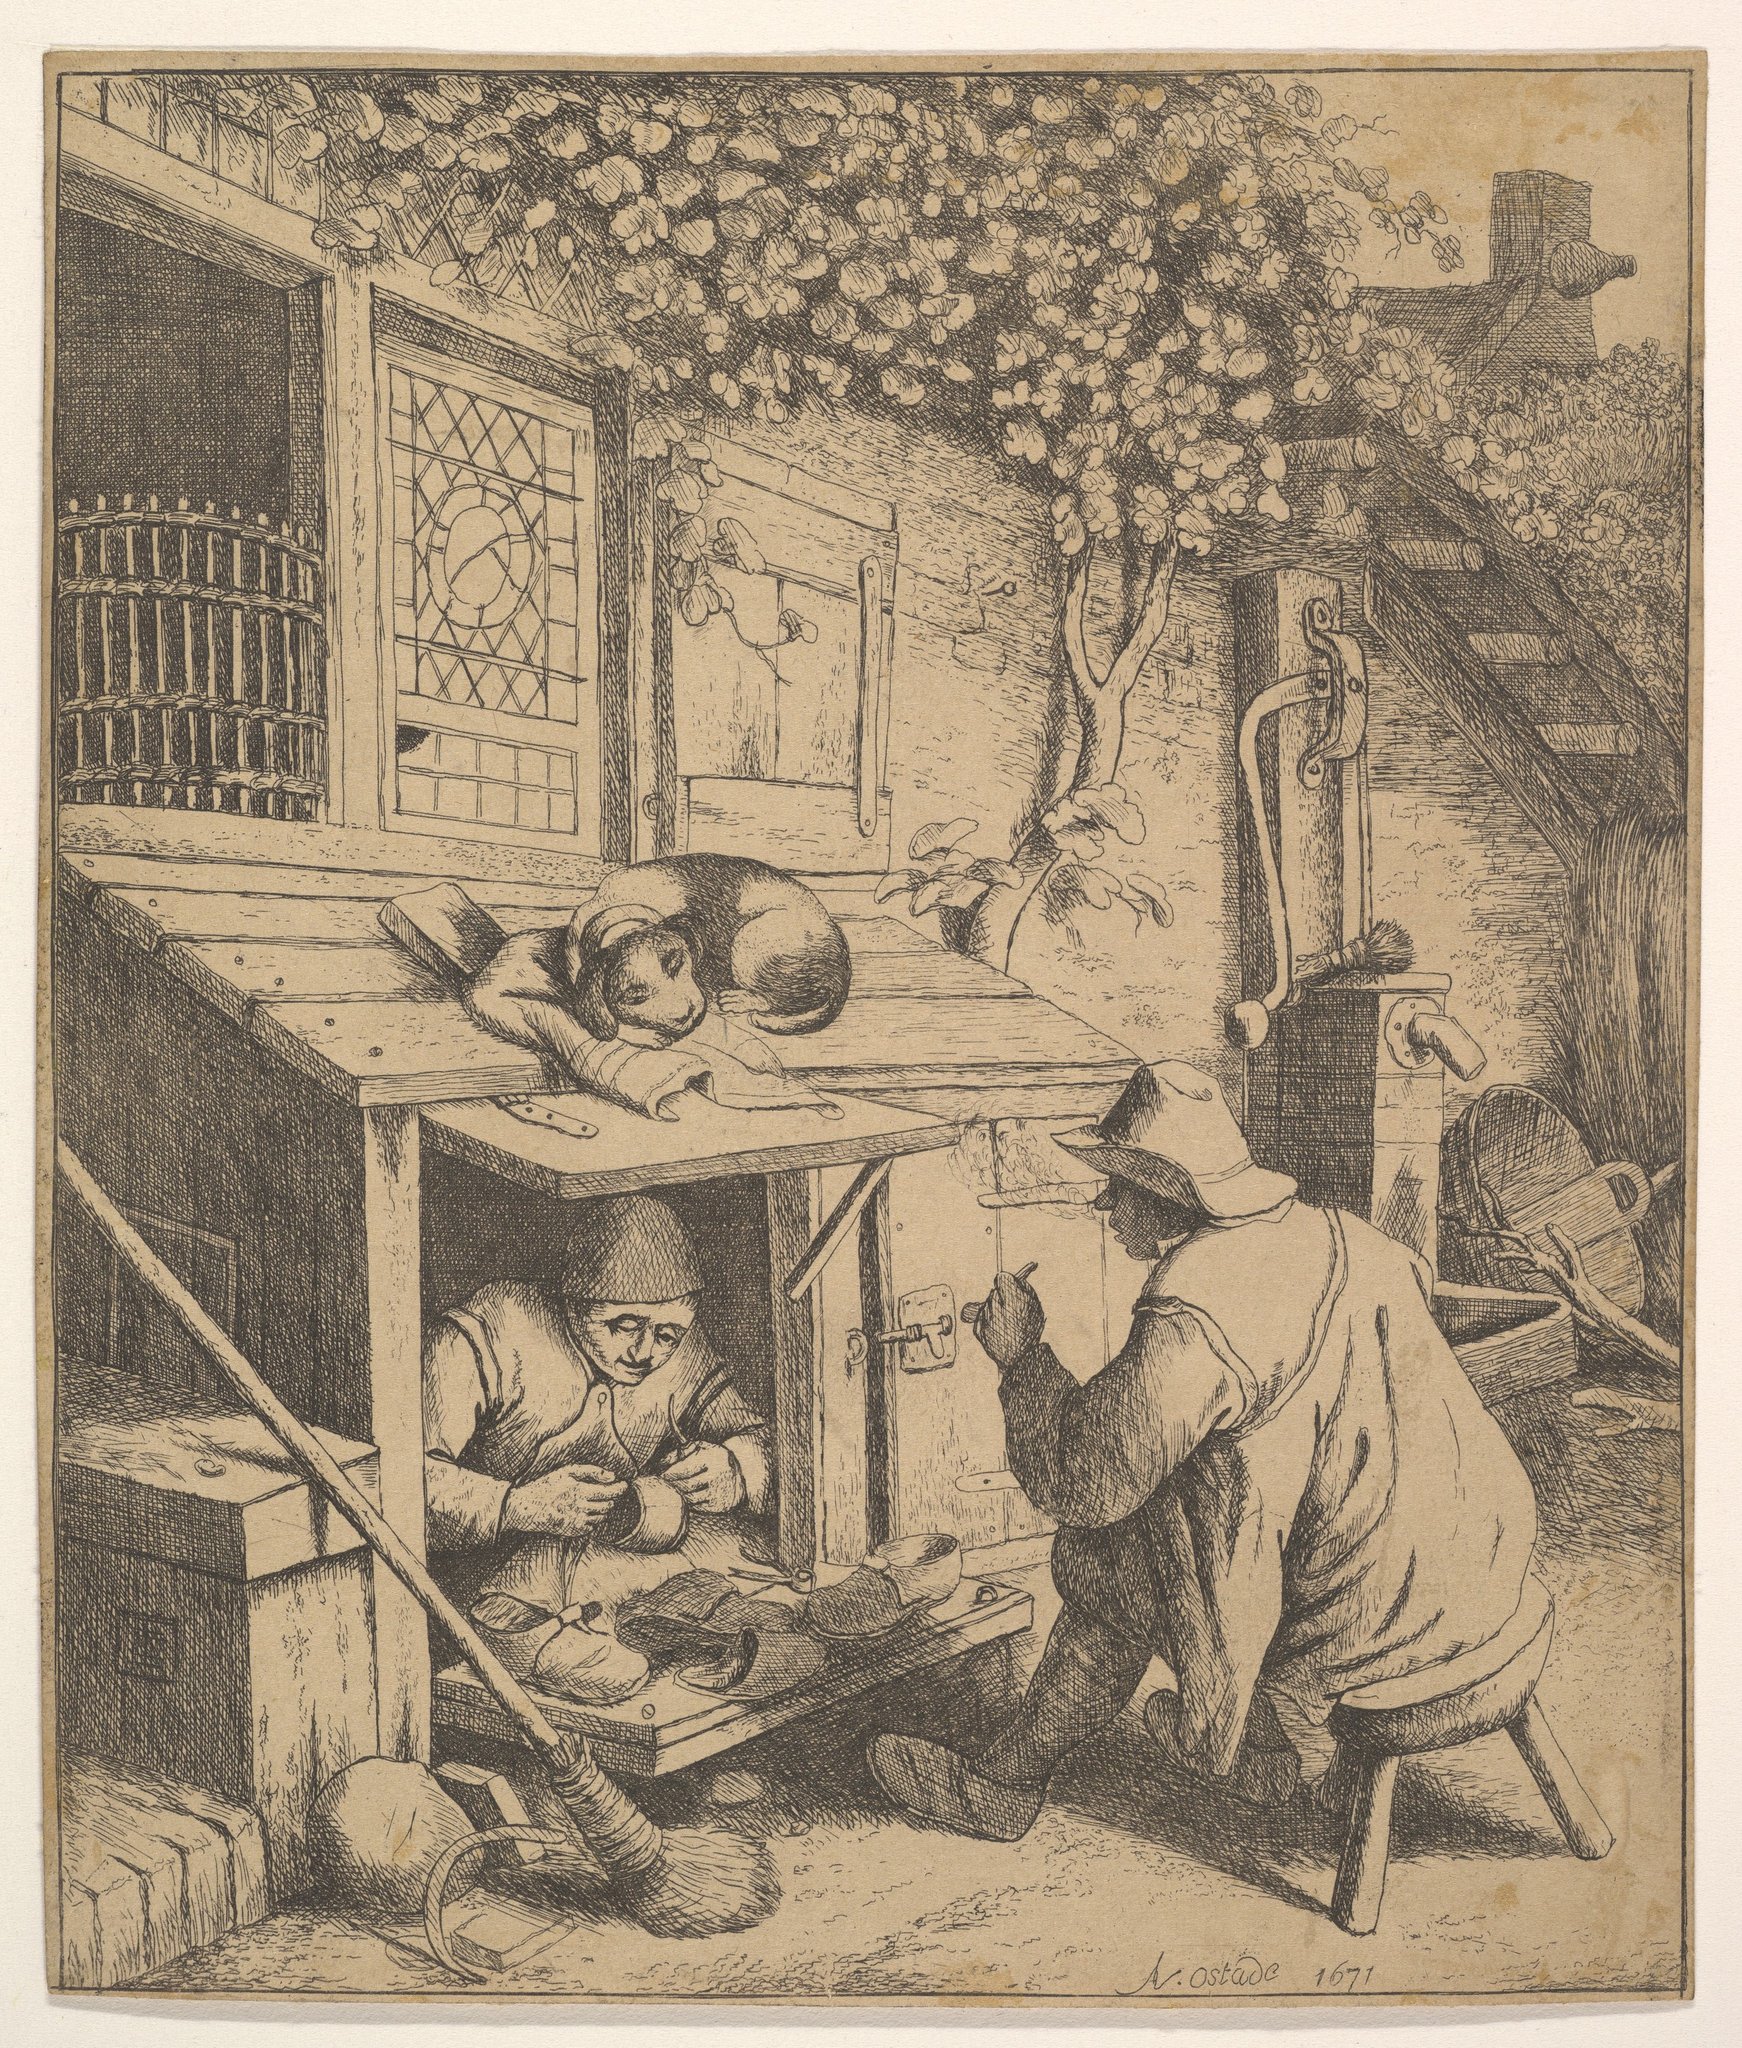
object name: print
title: The Cobbler (copy)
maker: adriaen van ostade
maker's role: artist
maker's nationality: dutch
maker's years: 1610-1685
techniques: etching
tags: shoes,men,dogs,working